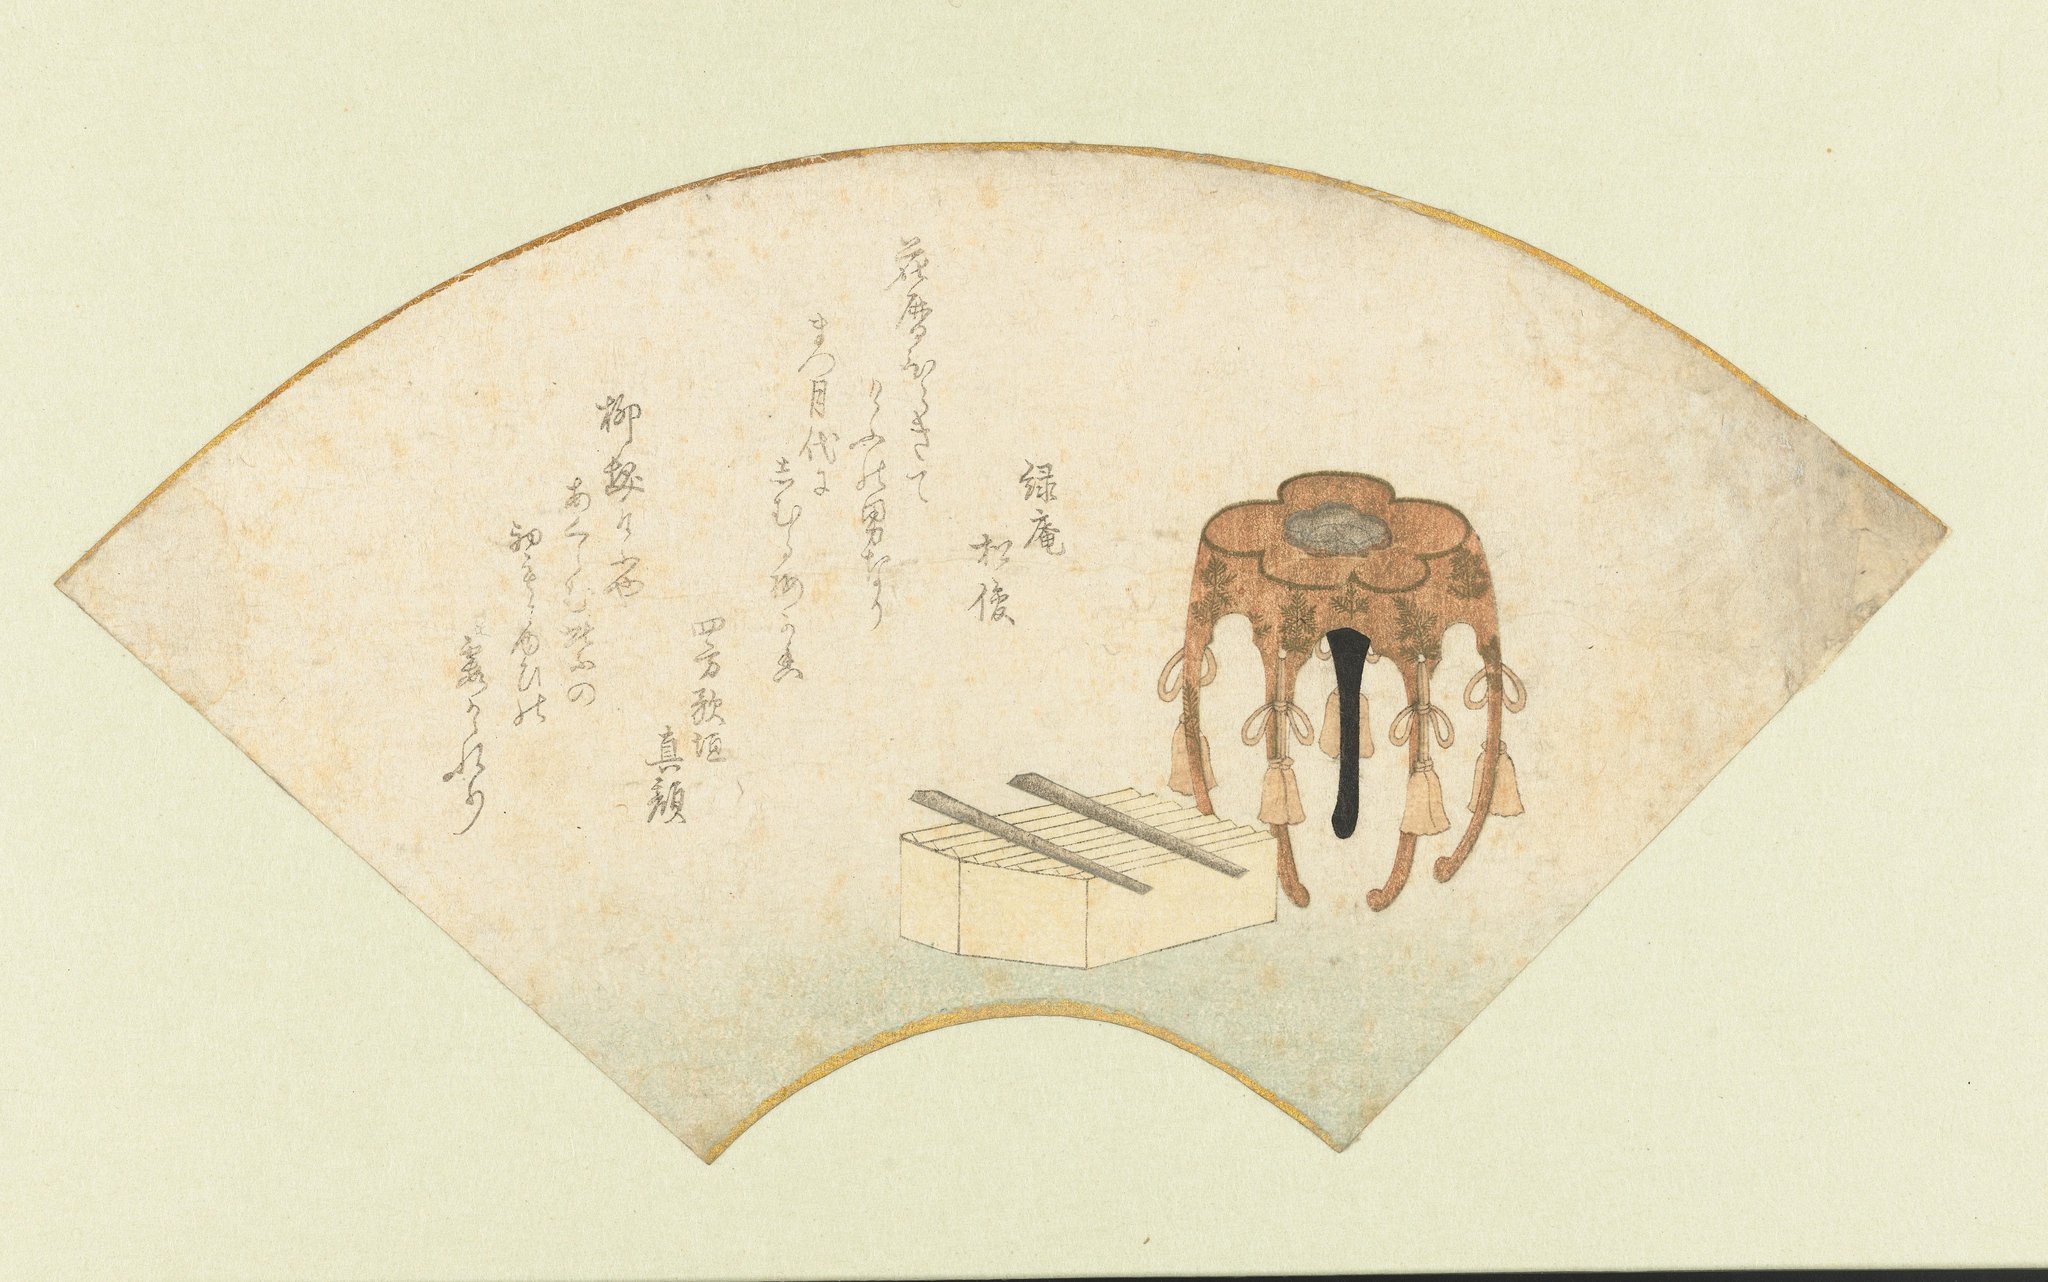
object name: print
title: Waaiervormige prent met gelakt tafeltje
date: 1810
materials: paper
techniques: woodcut, polish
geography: japan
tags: fan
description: Een surimono is een luxe uitgevoerde prent waarop beeld met één of meerdere gedichten gecombineerd is. Bij het drukken van een surimono werd vaak gebruik gemaakt van dikker papier, blinddruk en metaal pigmenten, zoals koper- en zilverpoeder. De prenten werden vaak in opdracht van dichters gemaakt en als exclusief geschenk aan vrienden en relaties gegeven.